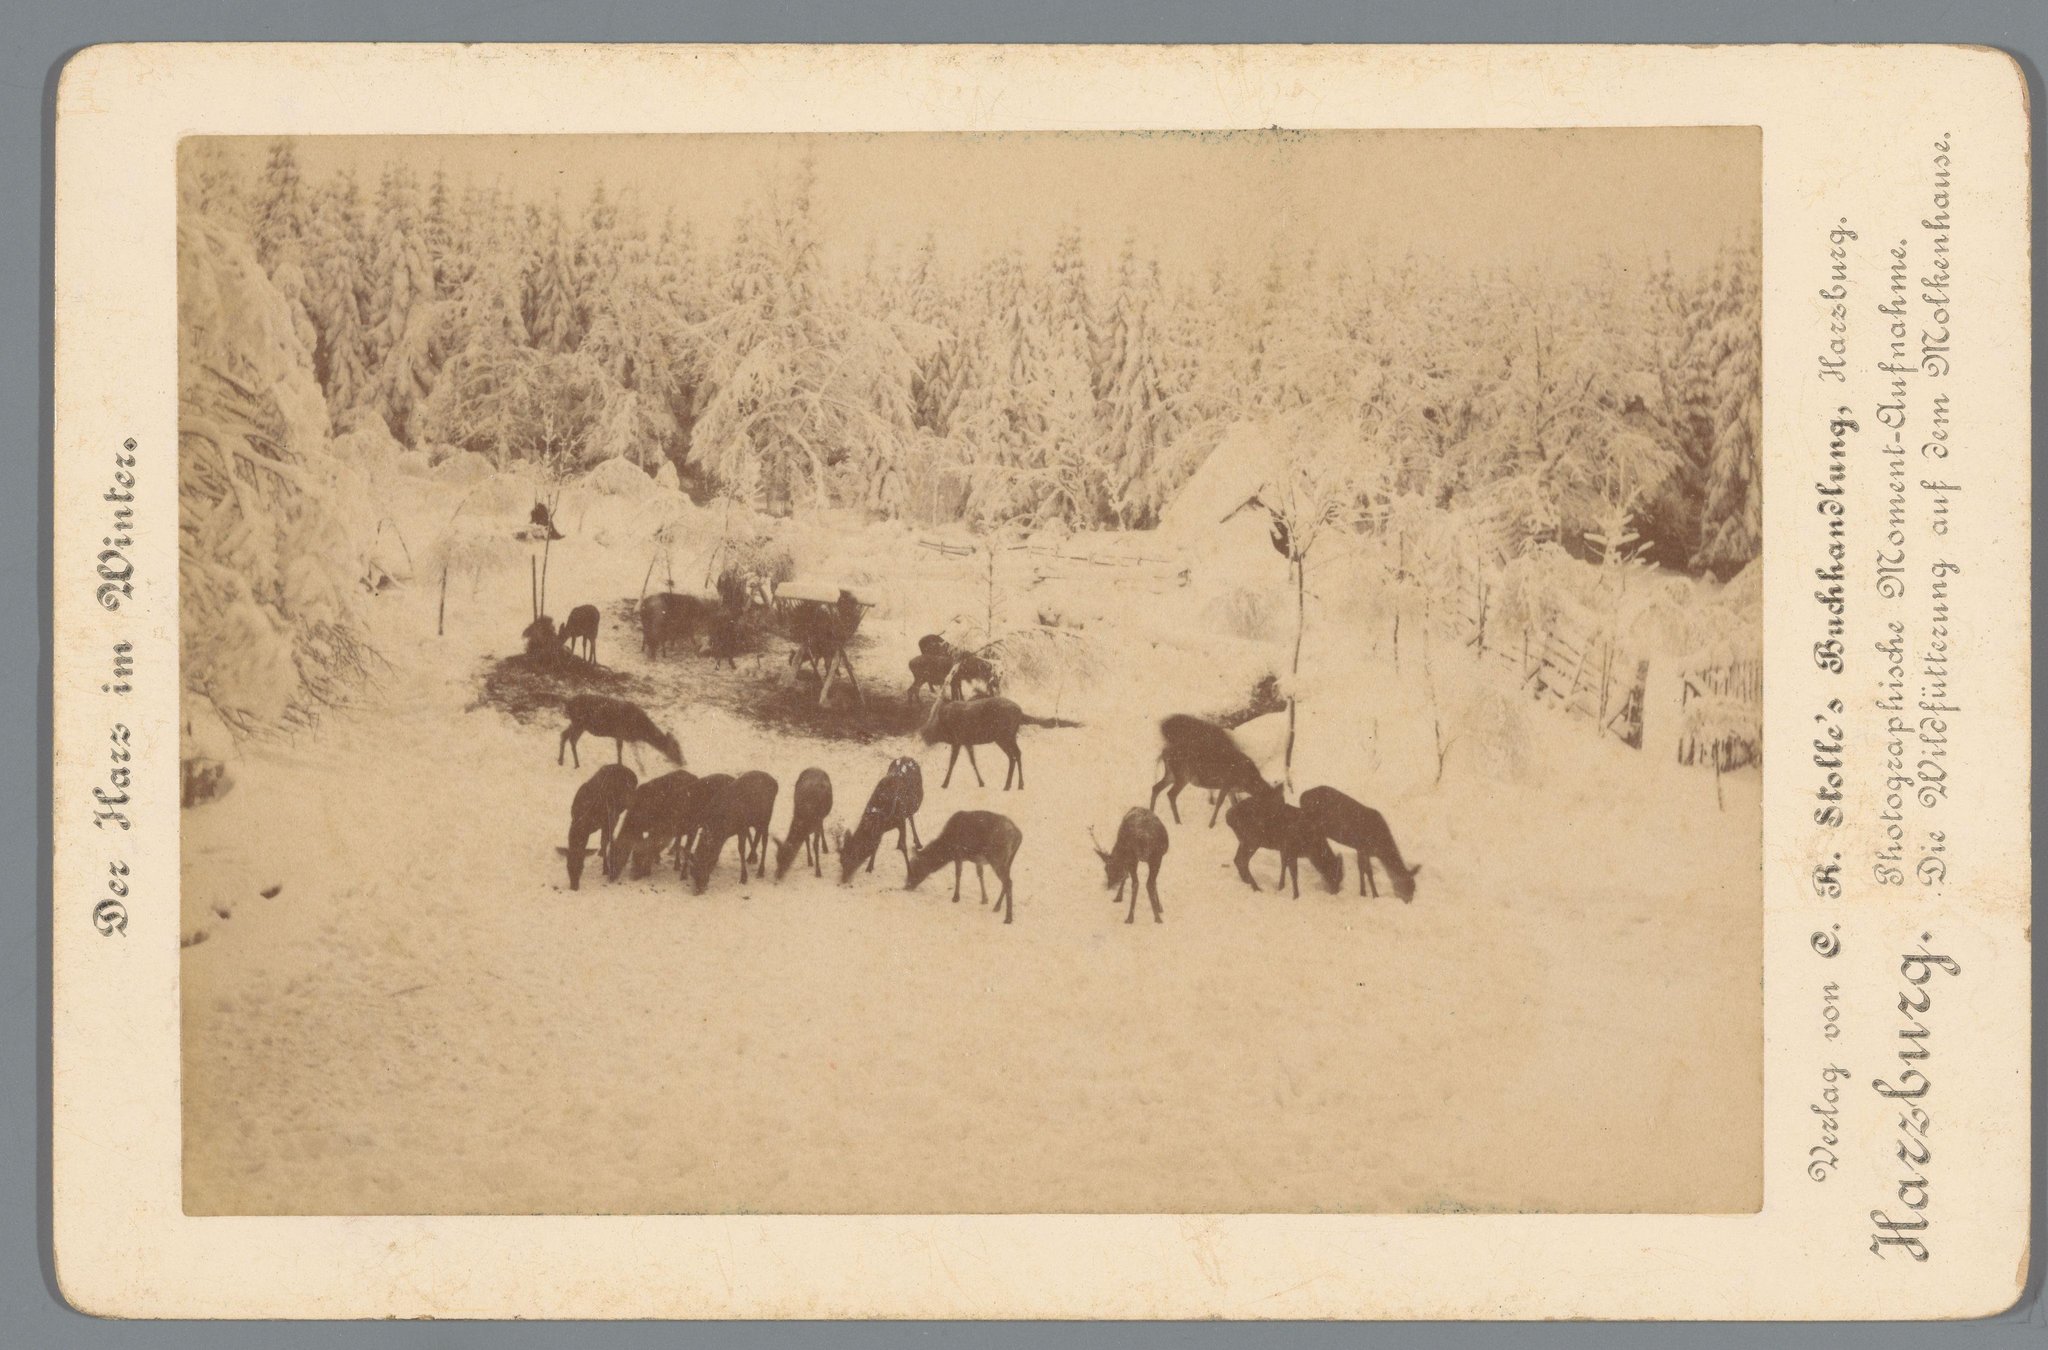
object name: cabinet photograph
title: Wilde herten worden gevoerd in de winter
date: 1850-1900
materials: cardboard, photographic support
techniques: albumen print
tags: hoofed animals: deer, feeding wild animals in winter